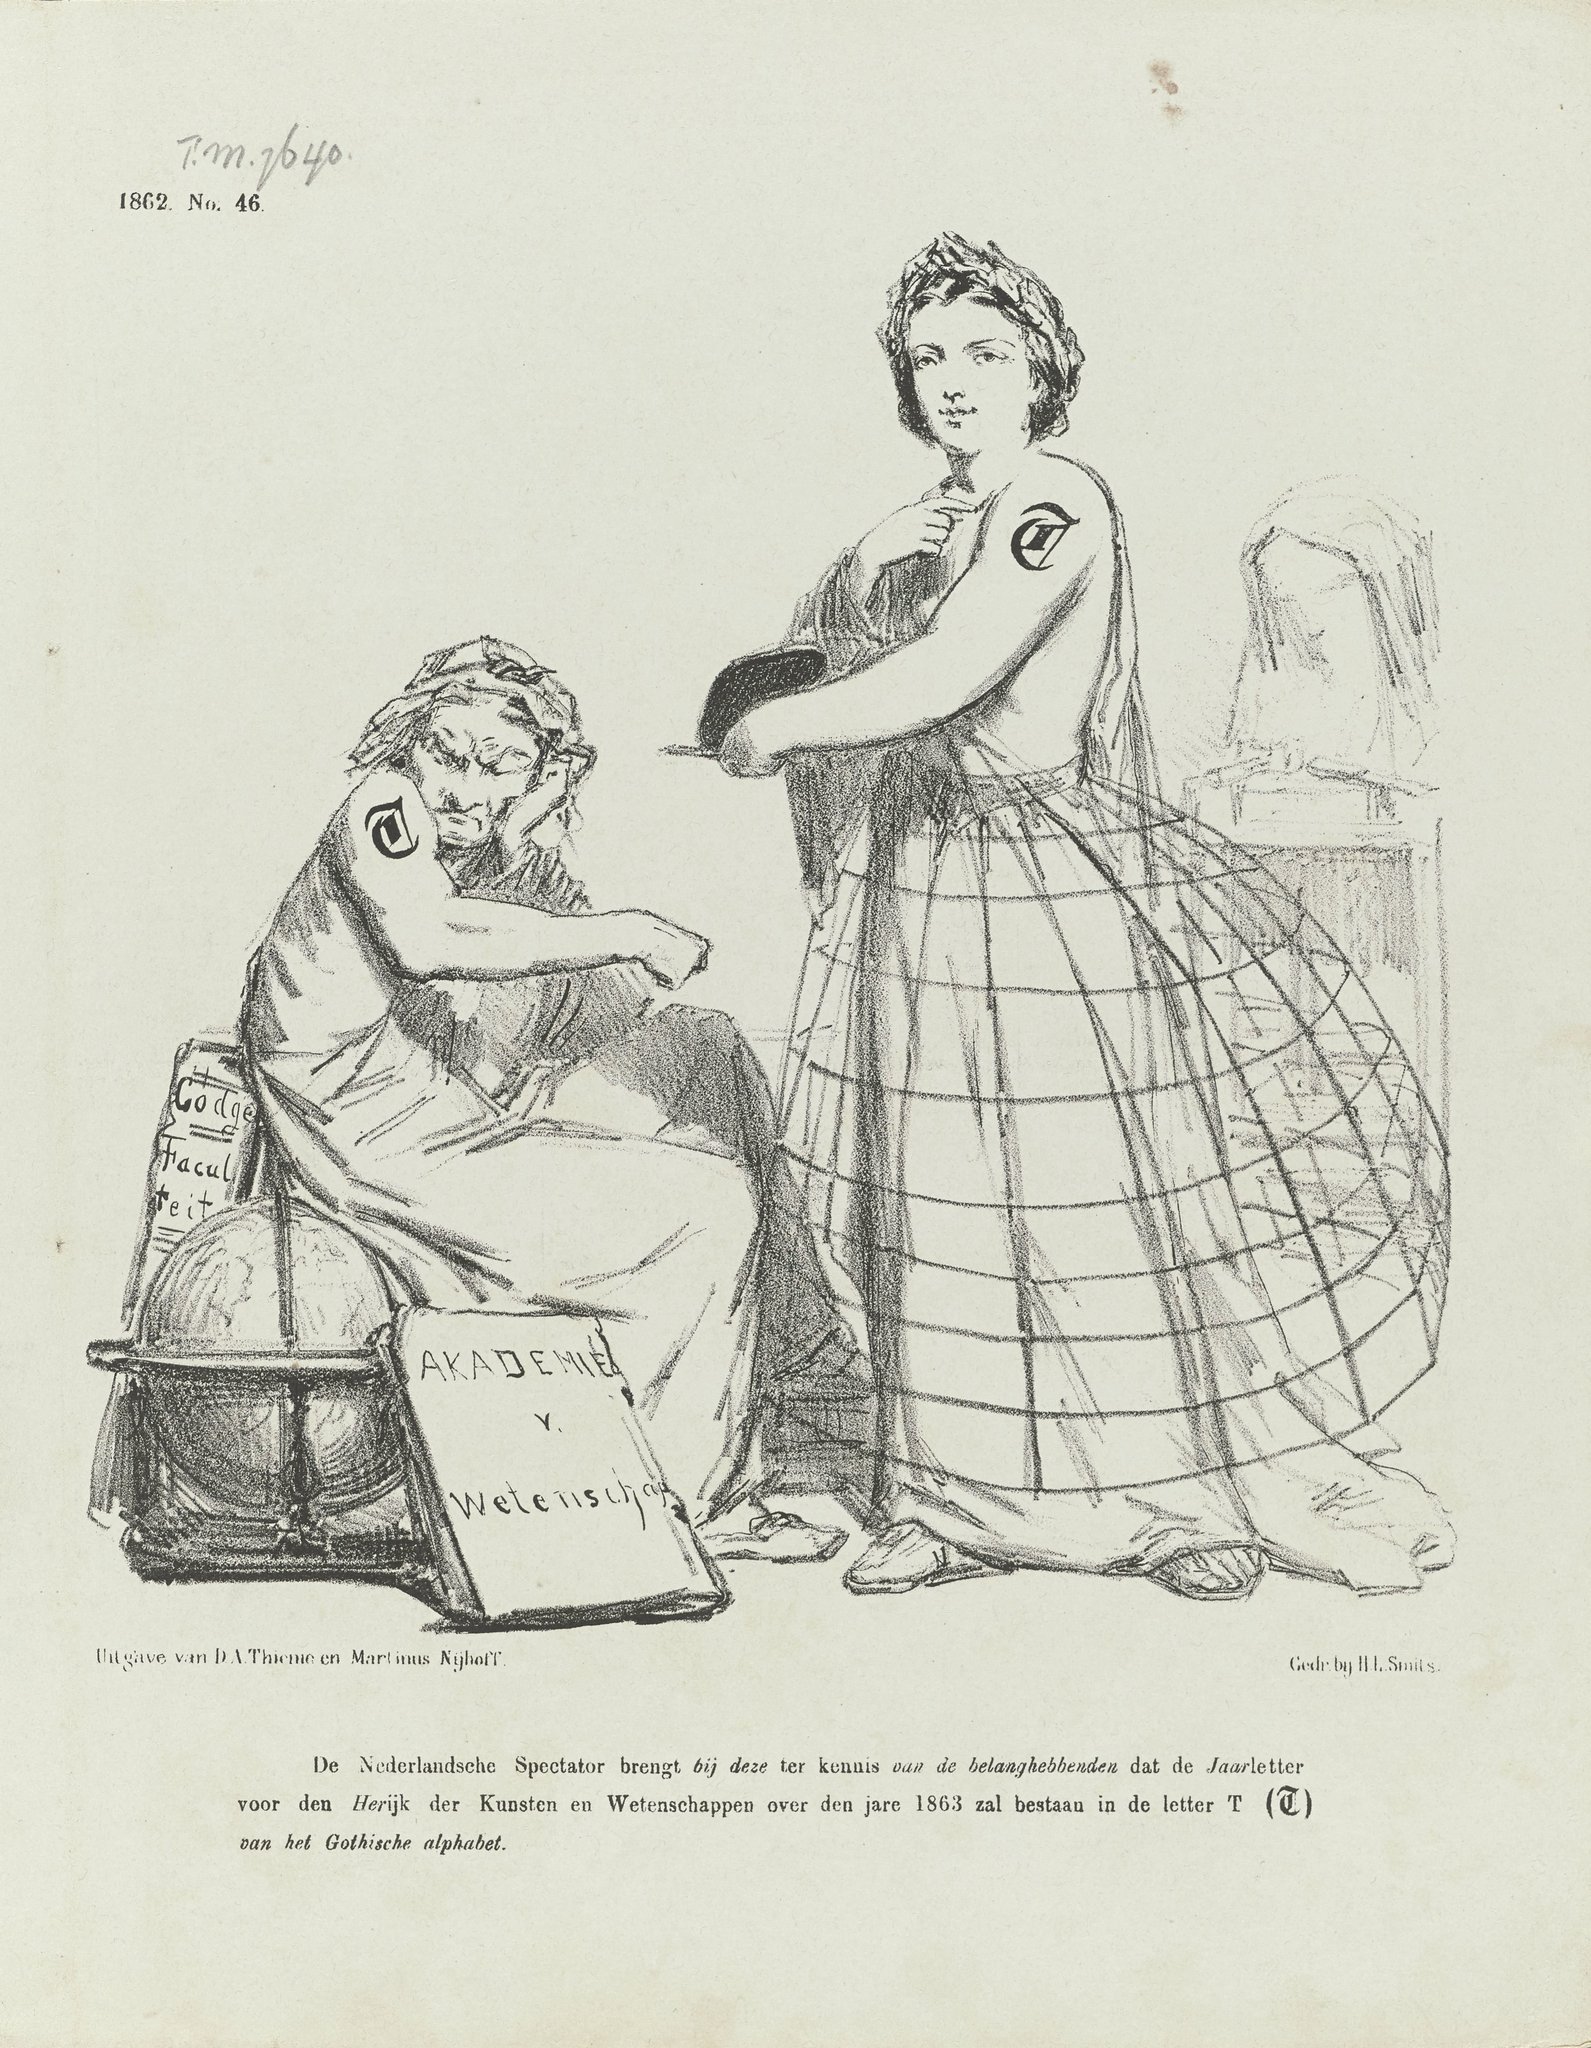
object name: print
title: Spotprent met de letter T, 1862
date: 1862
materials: paper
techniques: lithograph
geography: netherlands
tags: the hague, johan rudolf thorbecke, science and technology, symbolic representations, allegories and emblems ~ art; 'arte' (ripa)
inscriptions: collector's mark: Lugt 2228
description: Spotprent met de Wetenschap en de Kunsten die beiden een brandmerk met de letter T dragen (naar aanleiding van opmerkingen van Thorbecke). Plaat verschenen bij het weekblad De Nederlandsche Spectator, nr. 46, 15 november 1862.